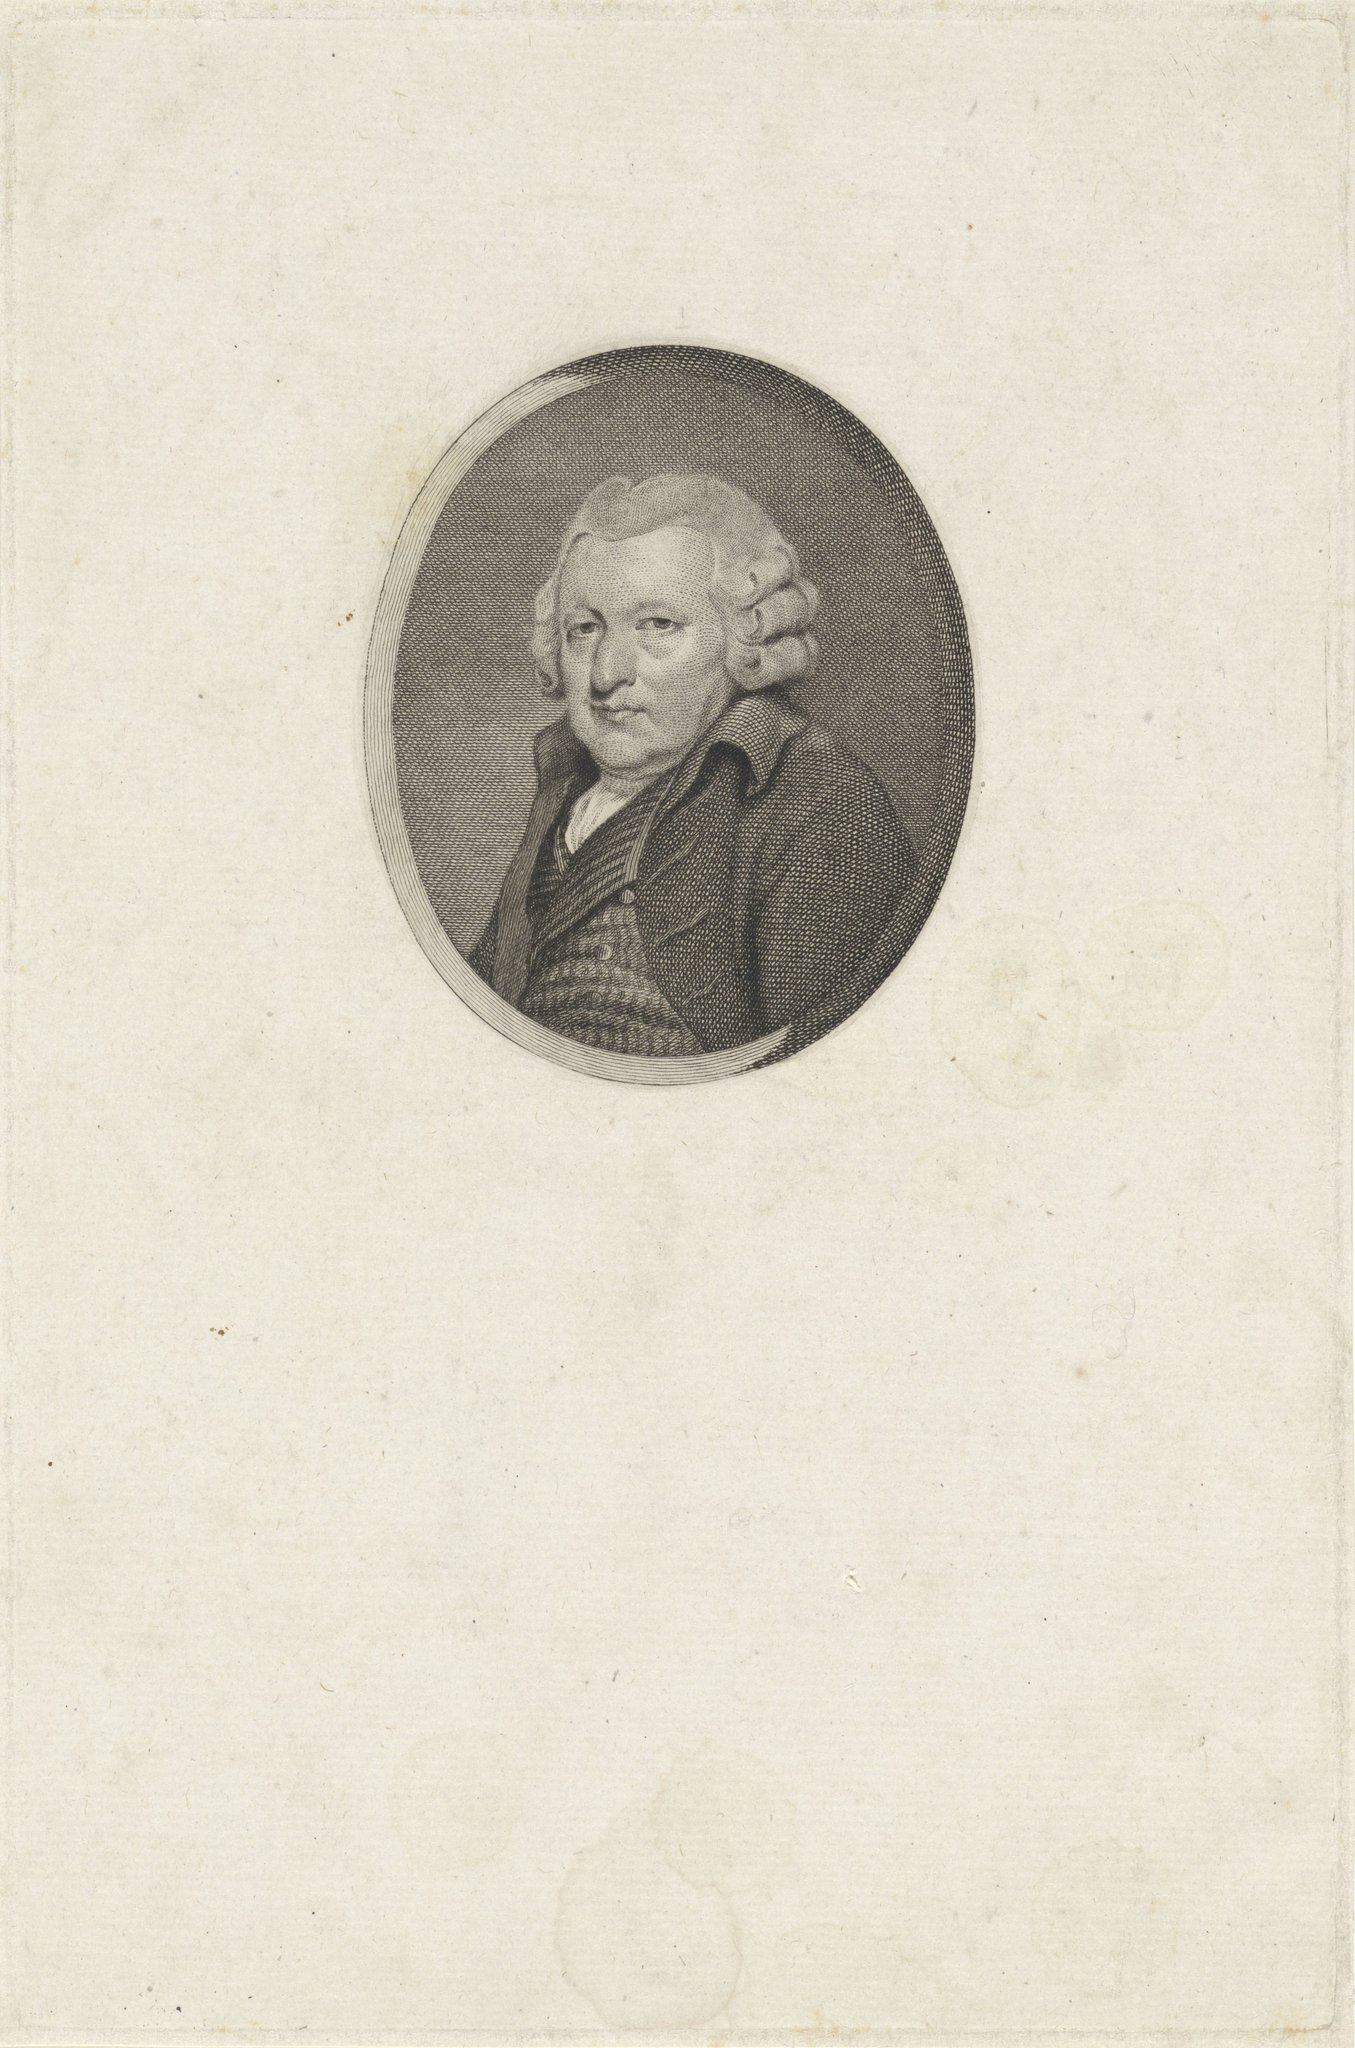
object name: print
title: Portret van Koenraad Hovens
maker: reinier vinkeles (i)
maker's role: draughtsman, print maker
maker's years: 1741-1816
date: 1786-1809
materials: paper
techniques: engraving, etching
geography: amsterdam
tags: koenraad hovens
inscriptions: collector's mark: Lugt 2228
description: Latere staat prent ook gebruikt als boekillustratie in: Wagenaar, Jan. Vaderlandsche historie, (...) ten vervolge van Wagenaars Vaderlandsche historie. Dl. 1-43. Amsterdam: Johannes Allart, 1786-1809.